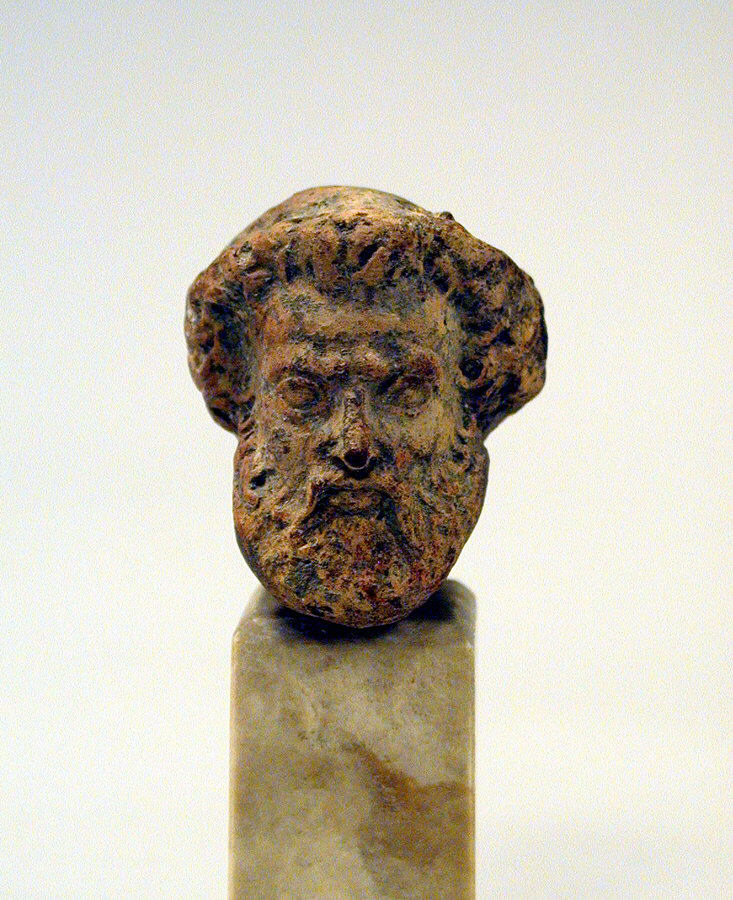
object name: portrait head of philosopher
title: Portrait head of philosopher ?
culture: greek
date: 400-301 BCE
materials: terracotta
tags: heads,men,portraits